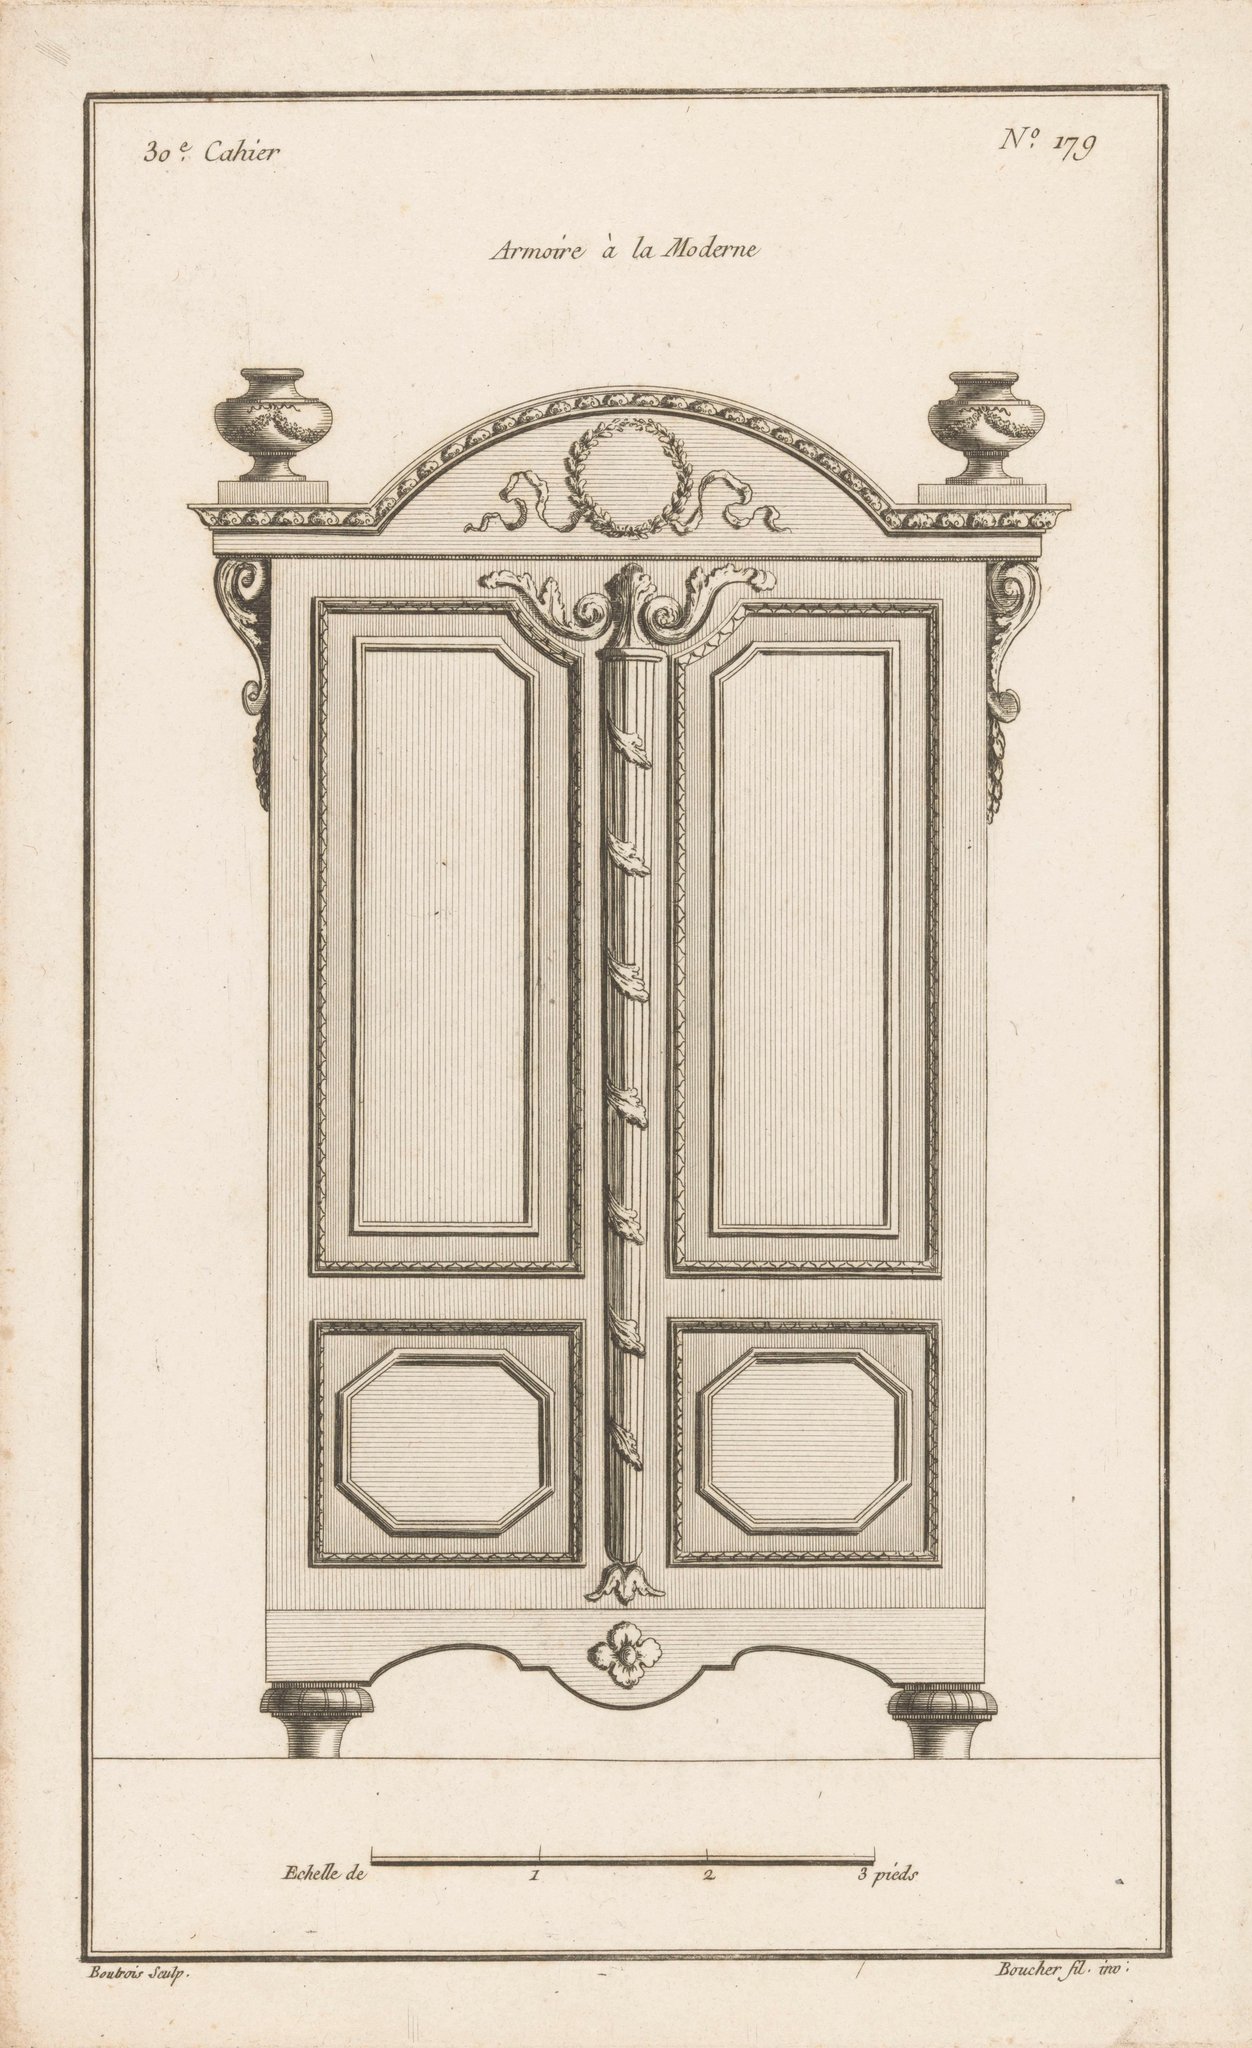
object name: ornament print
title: Kasten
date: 1772-1779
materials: paper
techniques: engraving, etching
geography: paris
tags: furniture for storage, garland, wreath, vase ~ ornament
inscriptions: collector's mark: Lugt 2760, collector's mark: Lugt 2228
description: Een kast gedecoreerd met een lauwerkrans en twee vazen. Prentnummer 179.